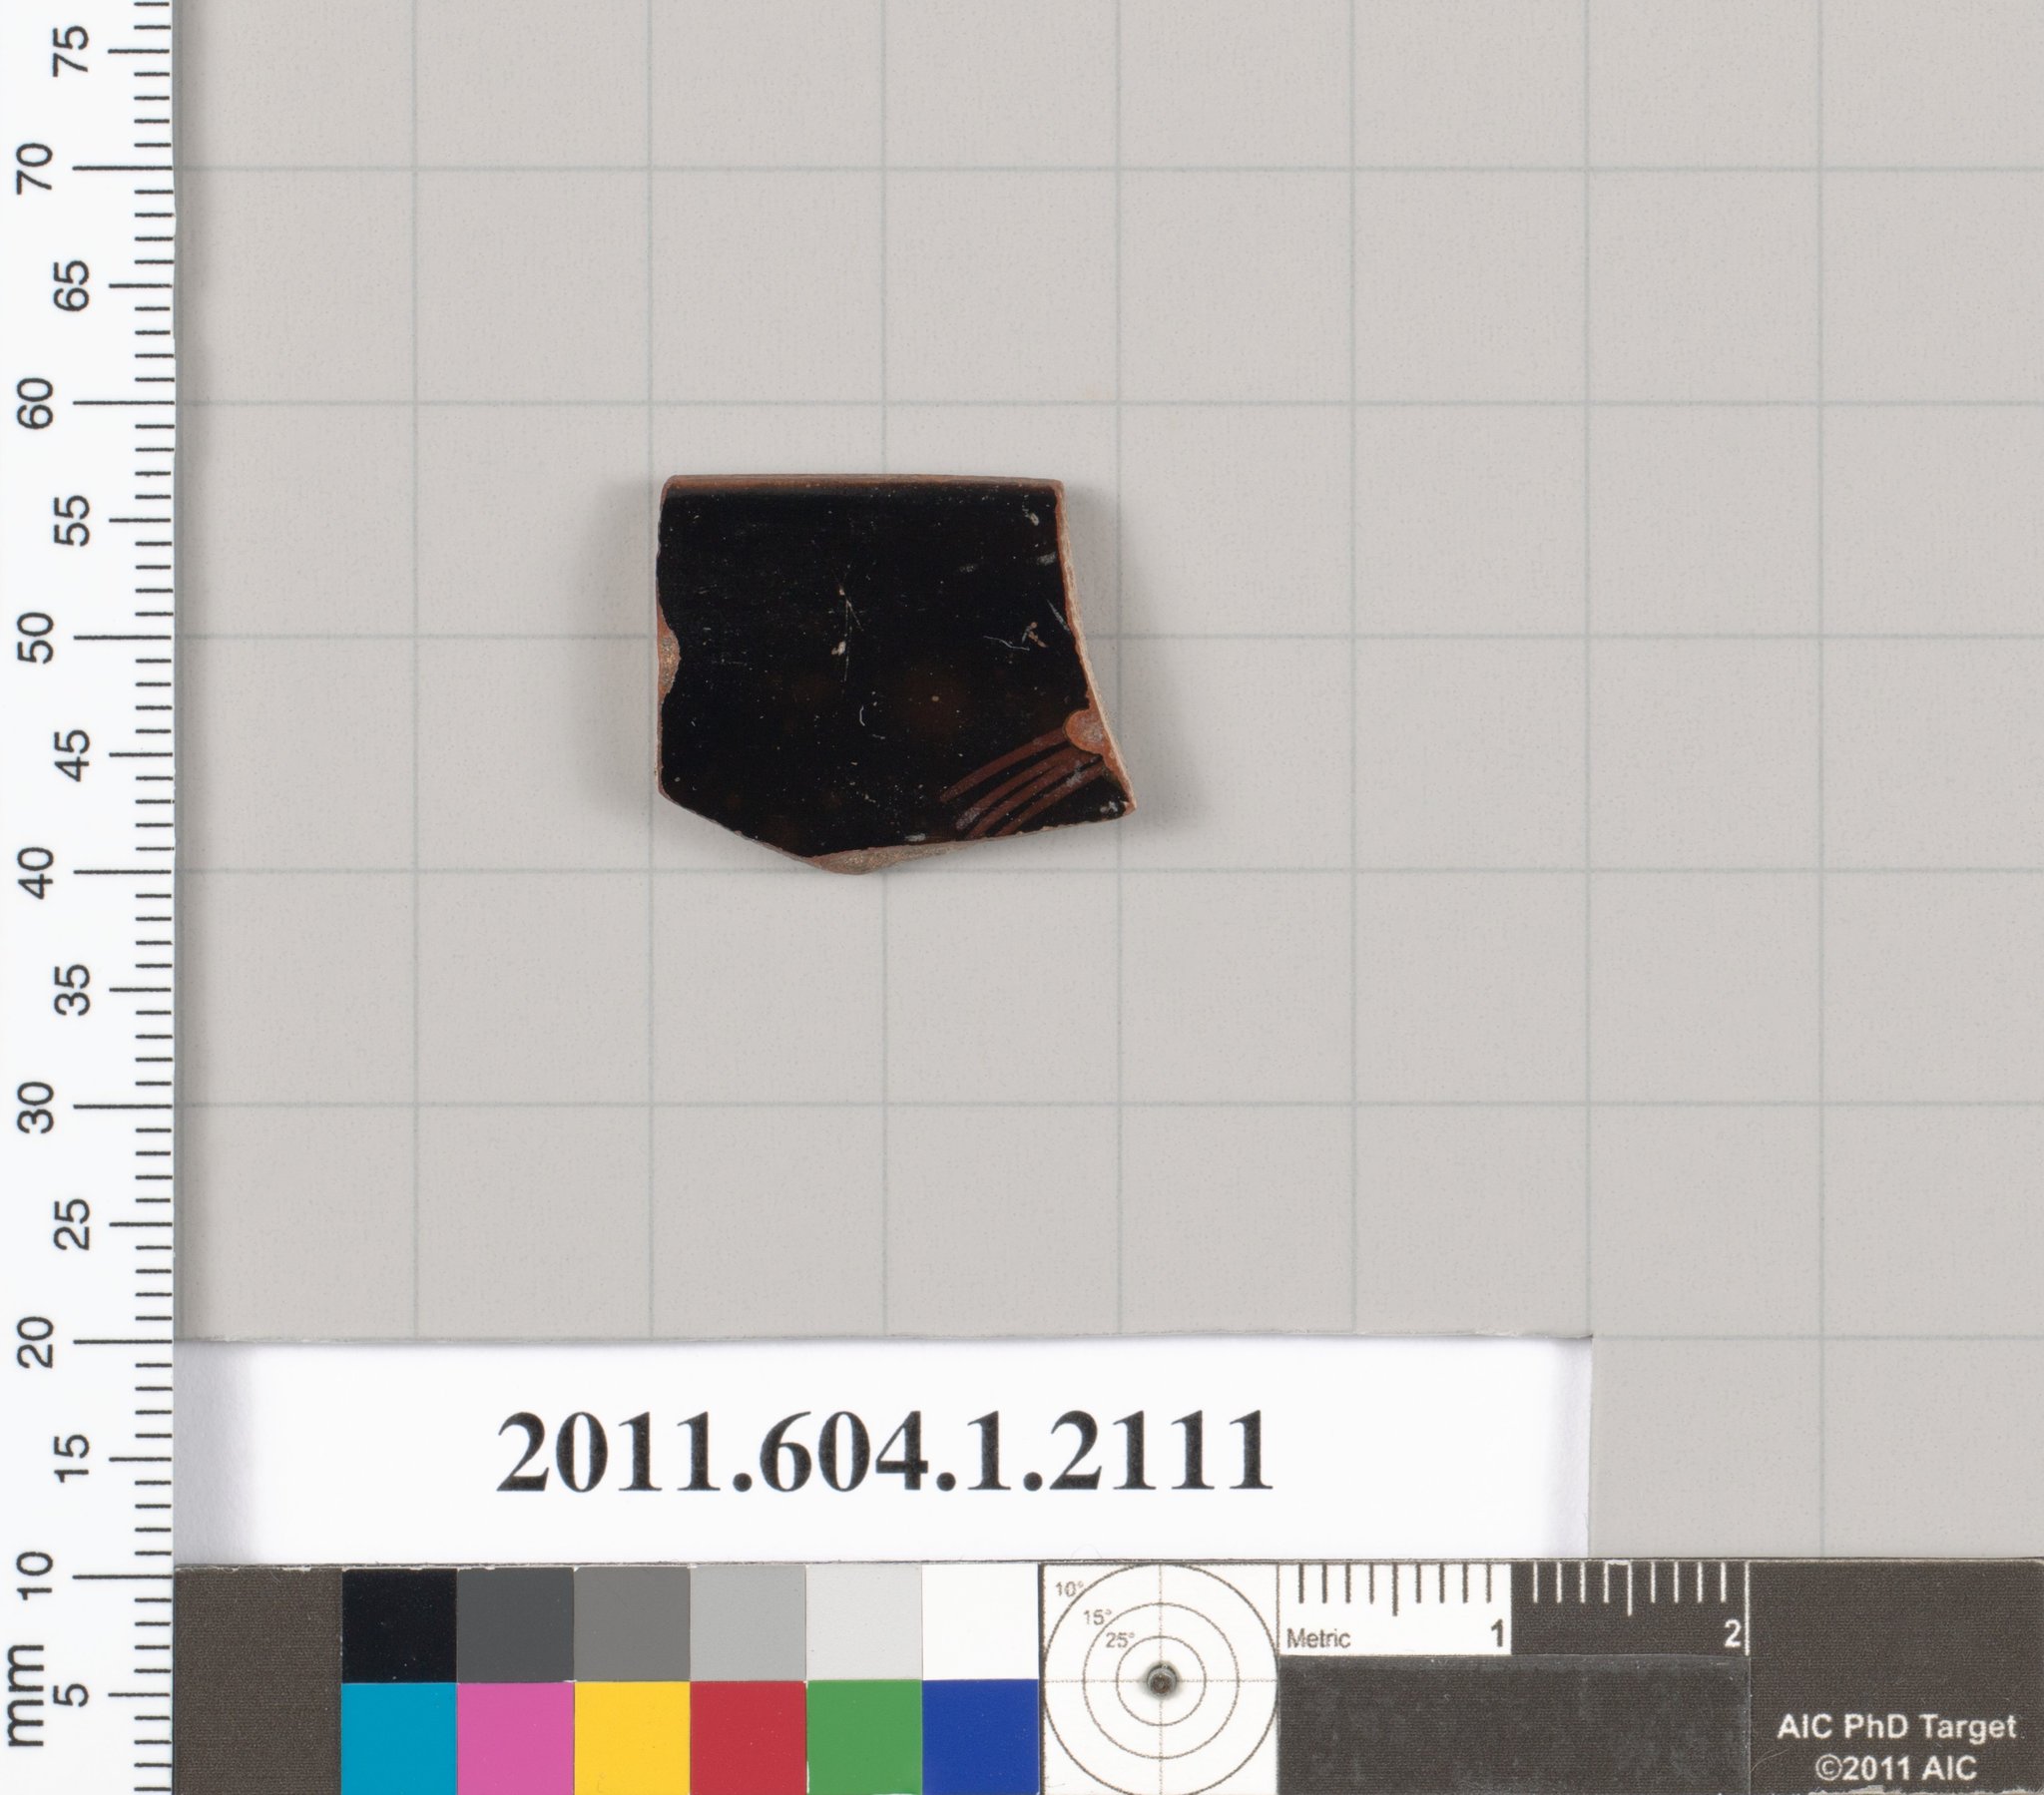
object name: kylix fragment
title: Terracotta rim fragment of a kylix (drinking cup)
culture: greek, attic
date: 490-480 BCE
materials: terracotta